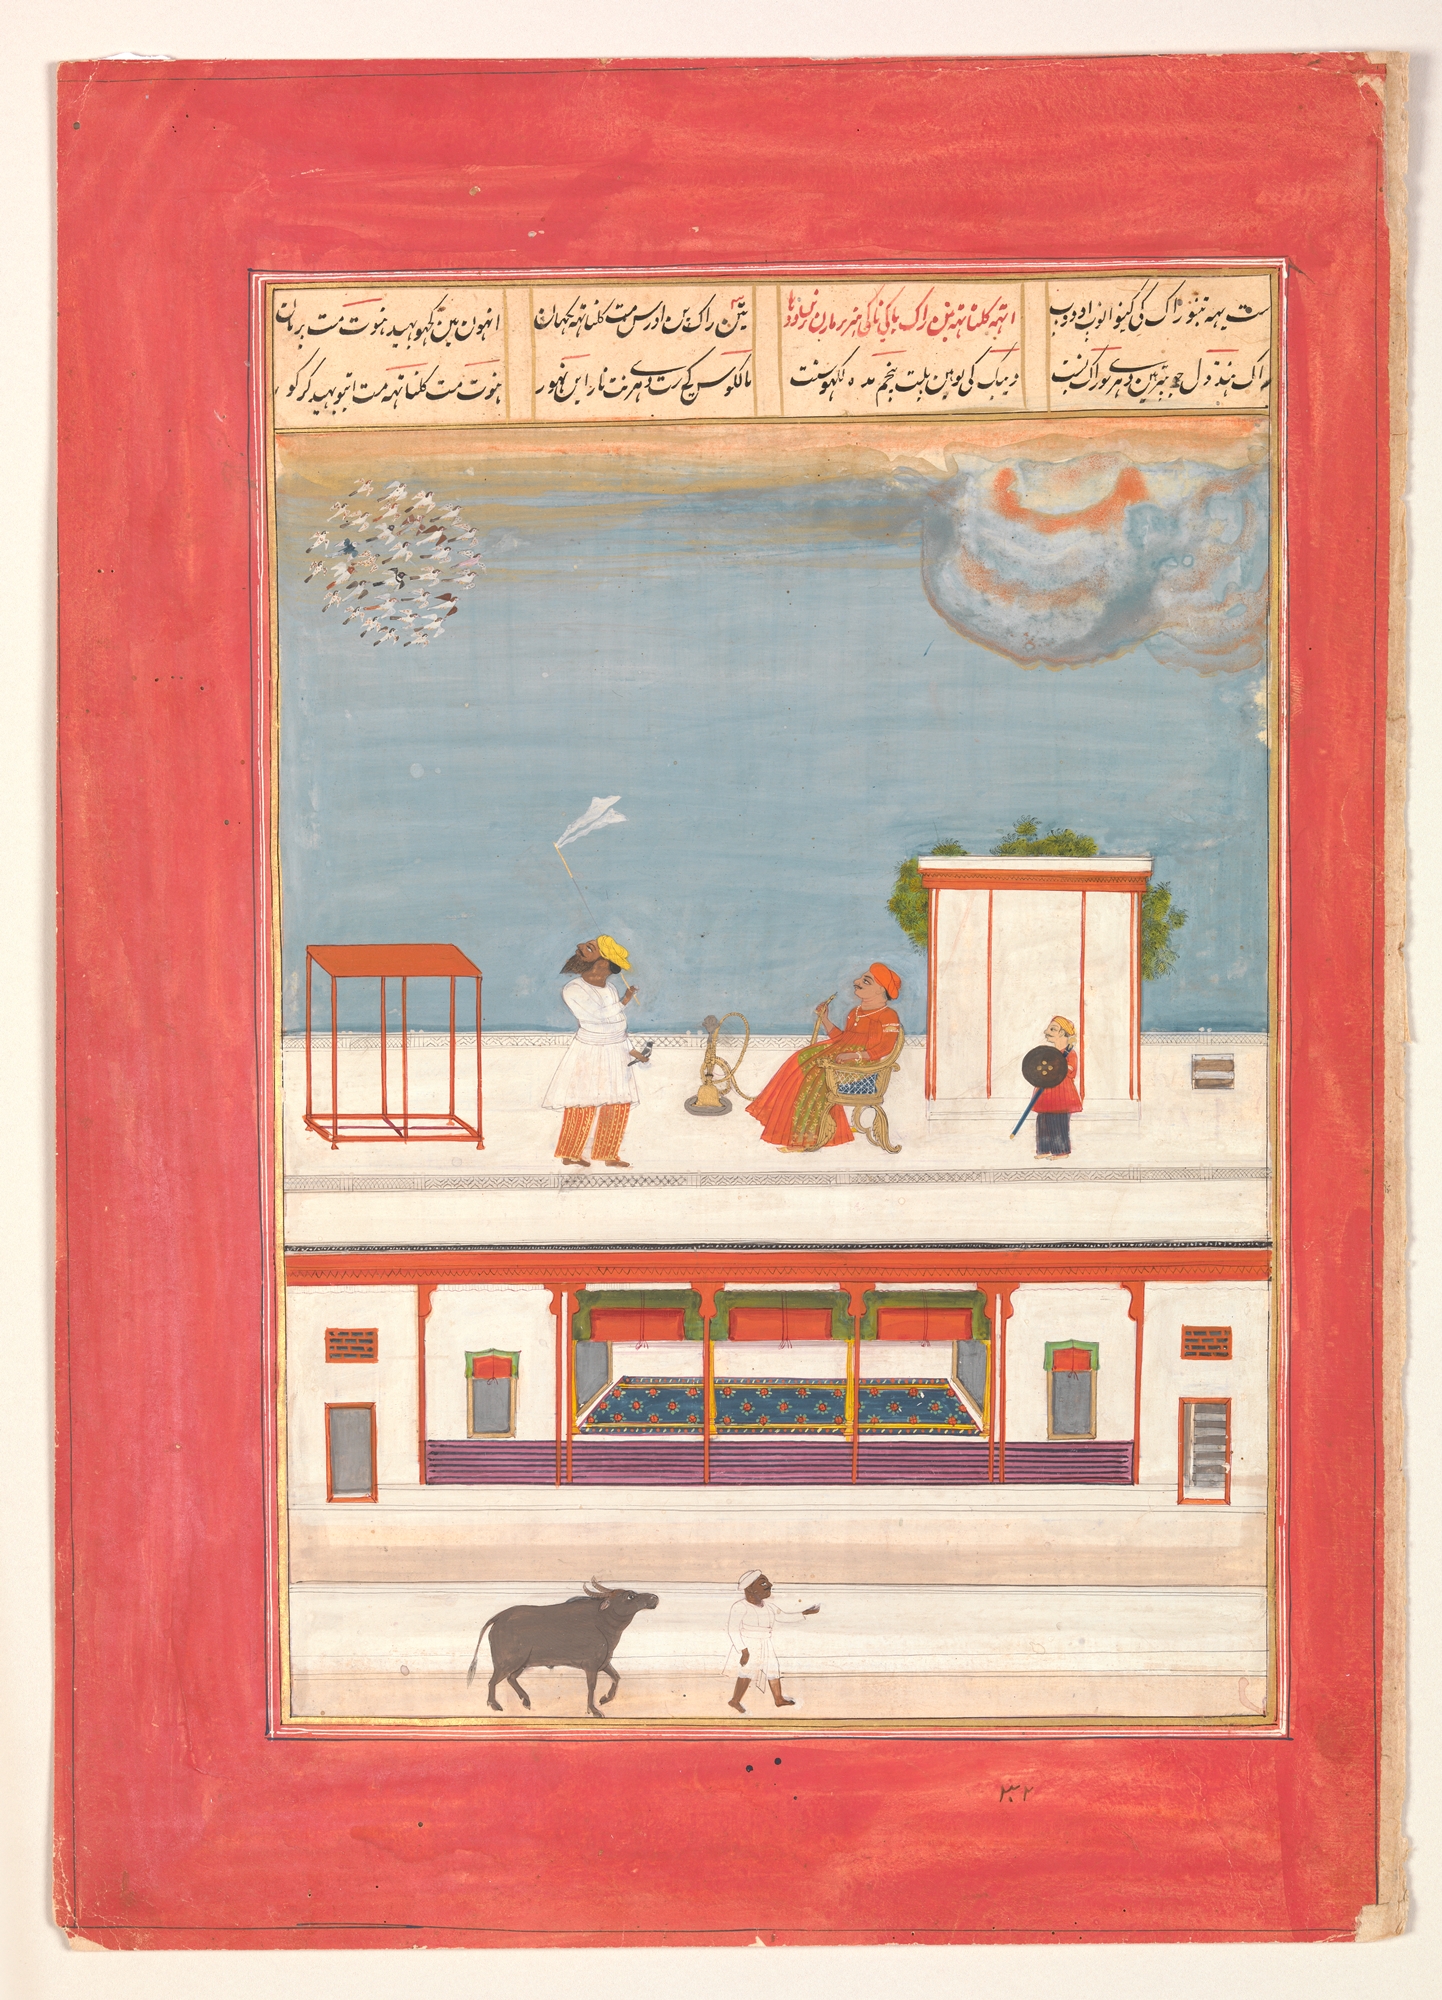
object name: folio from an illustrated manuscript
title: "A Raja Seated on a Palace Rooftop Smoking a Huqqa", Folio from a manuscript of the Raga Darshan of Anup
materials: paper, watercolor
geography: india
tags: animals,palaces,men,smoking,hookah